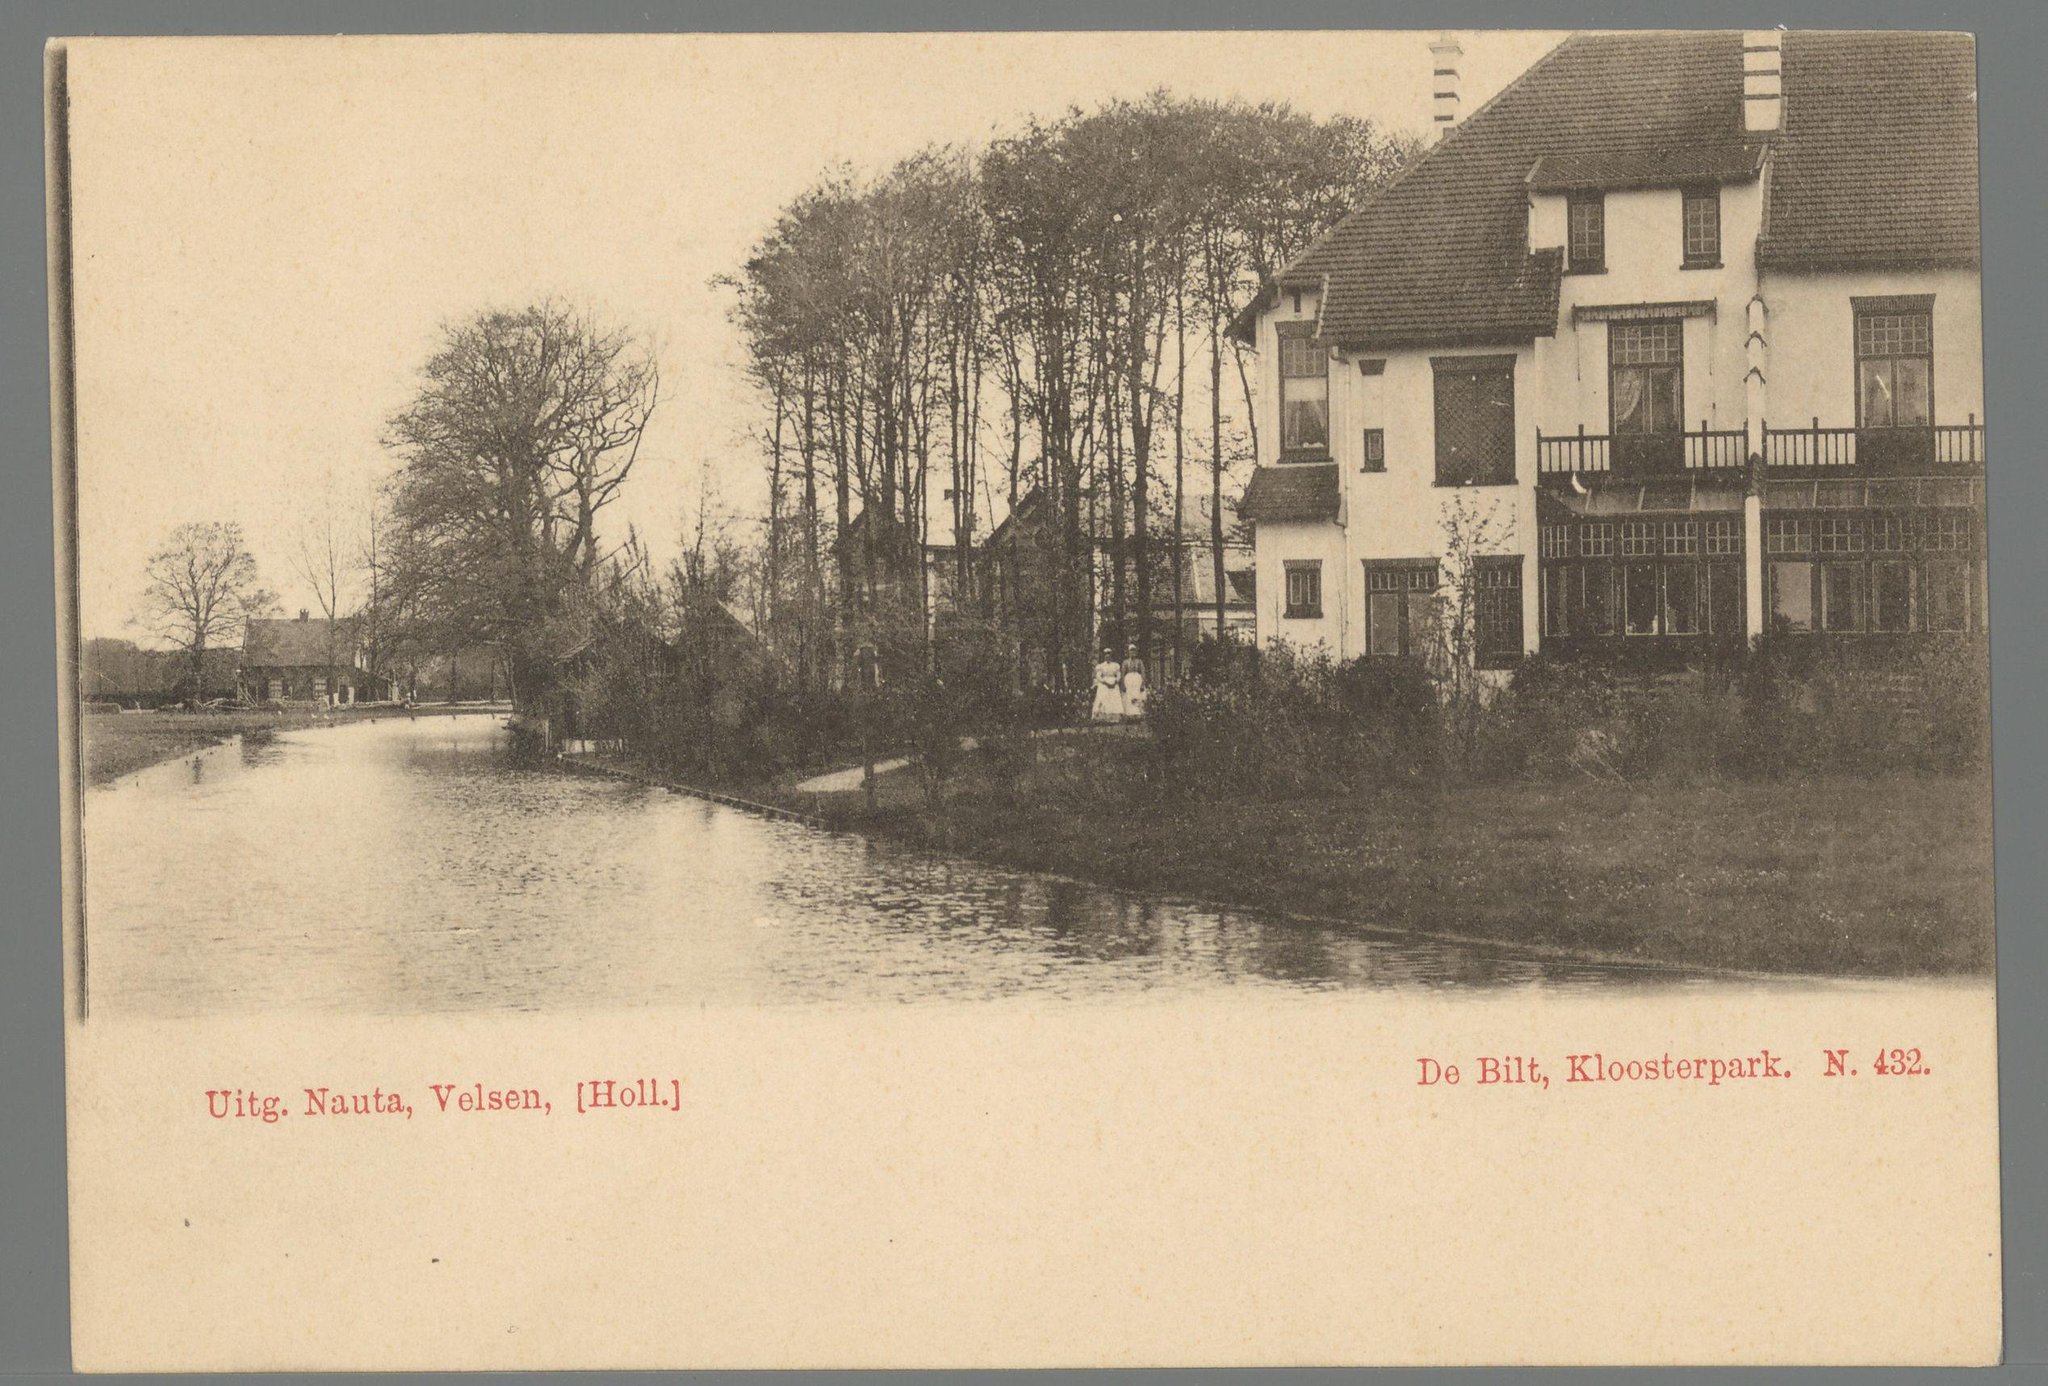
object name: photomechanical print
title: De Bilt, Kloosterpark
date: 1897-1905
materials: cardboard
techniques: photograph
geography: de bilt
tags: canals, waters (in village), villa